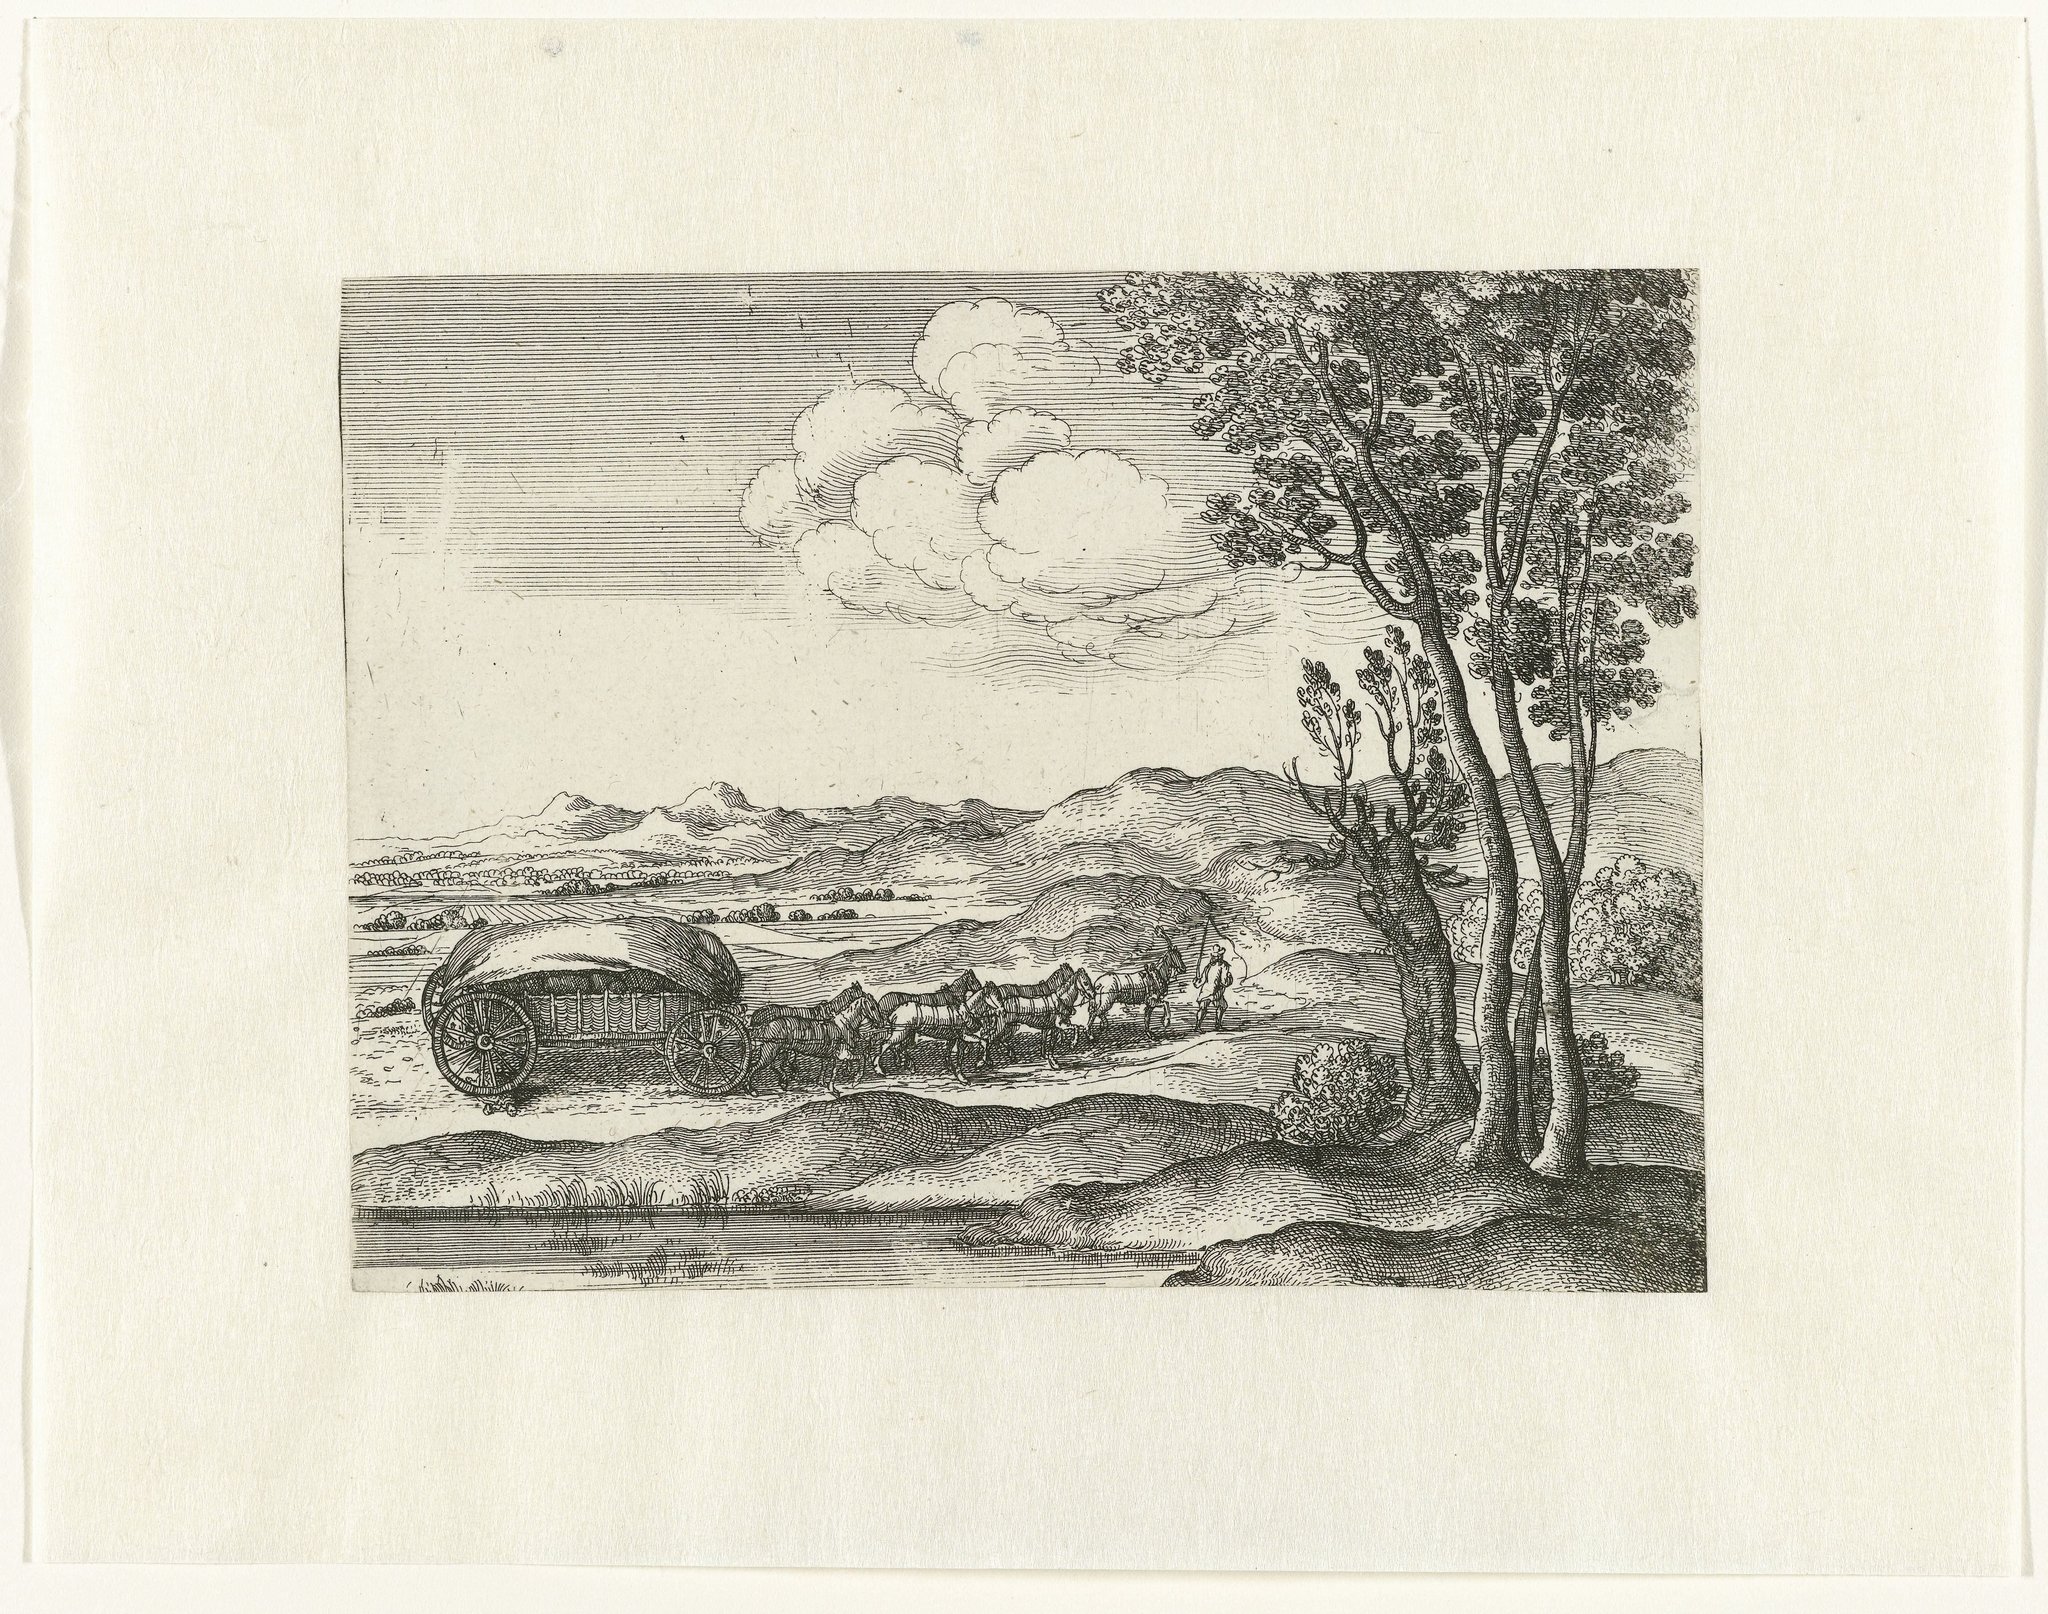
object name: print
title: Landschap met wagen voortgetrokken door paarden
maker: wenceslaus hollar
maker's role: draughtsman, print maker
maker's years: 1607-1677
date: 1625-1677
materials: paper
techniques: etching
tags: low hill country, (farm) wagon, freight wagon, cart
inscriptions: collector's mark: Lugt 2228